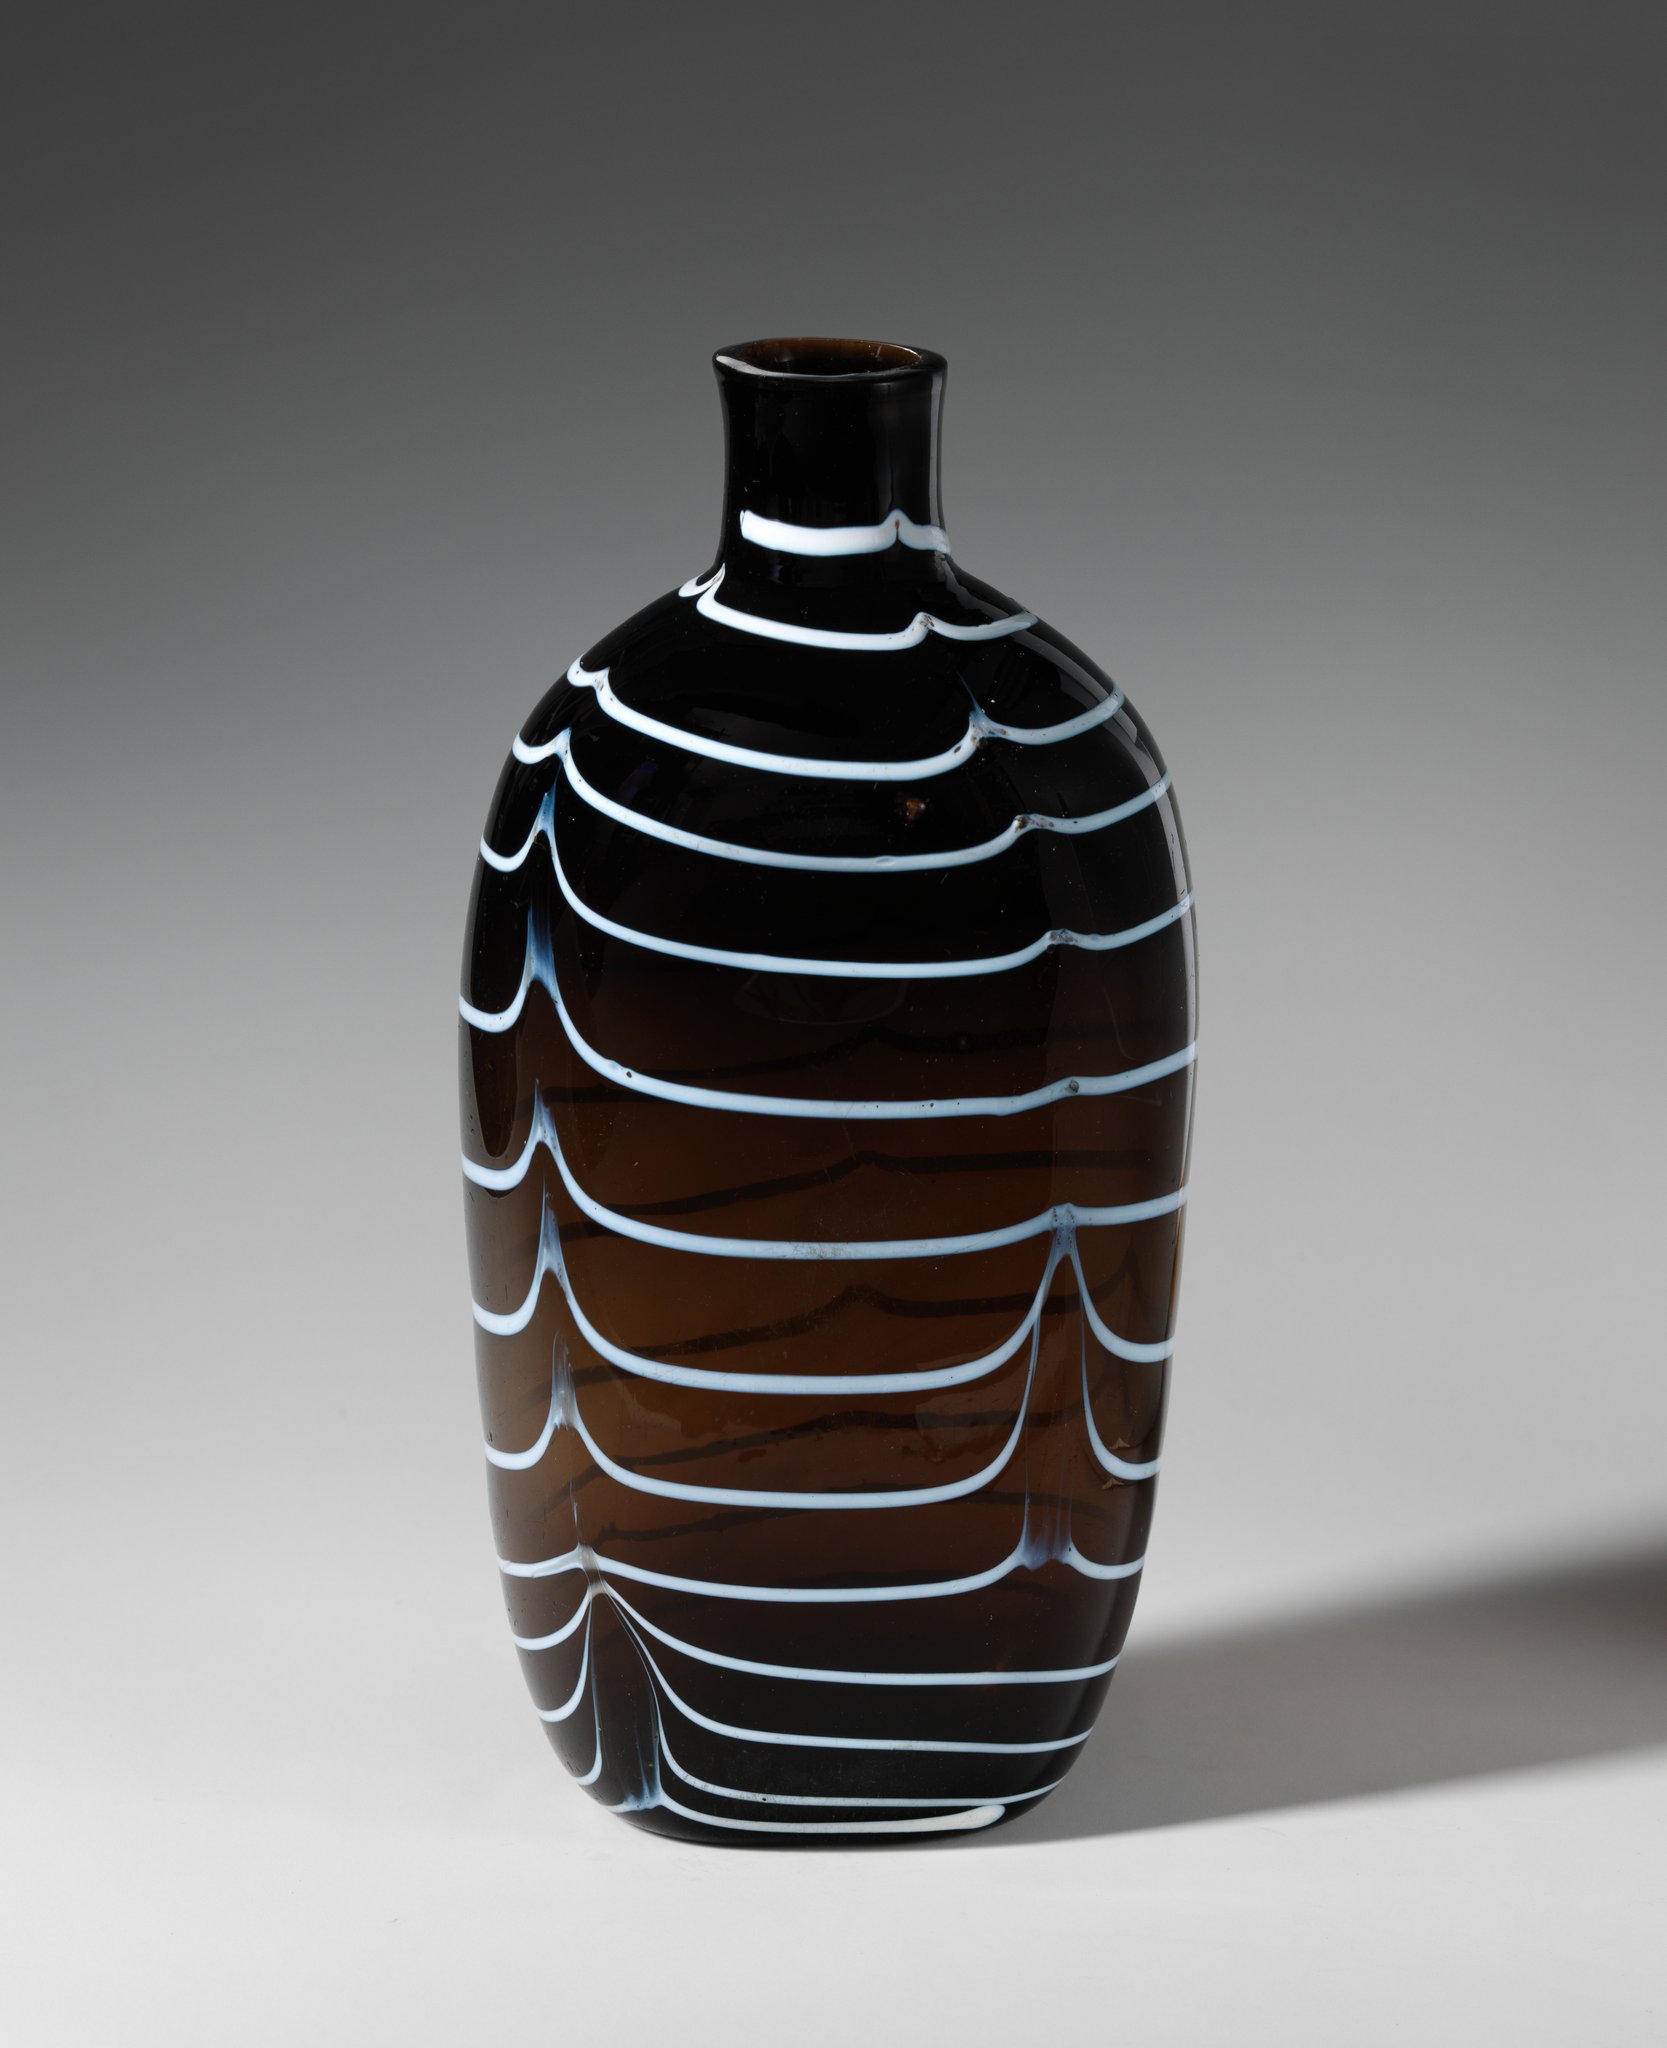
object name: flask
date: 1767-1833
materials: glass